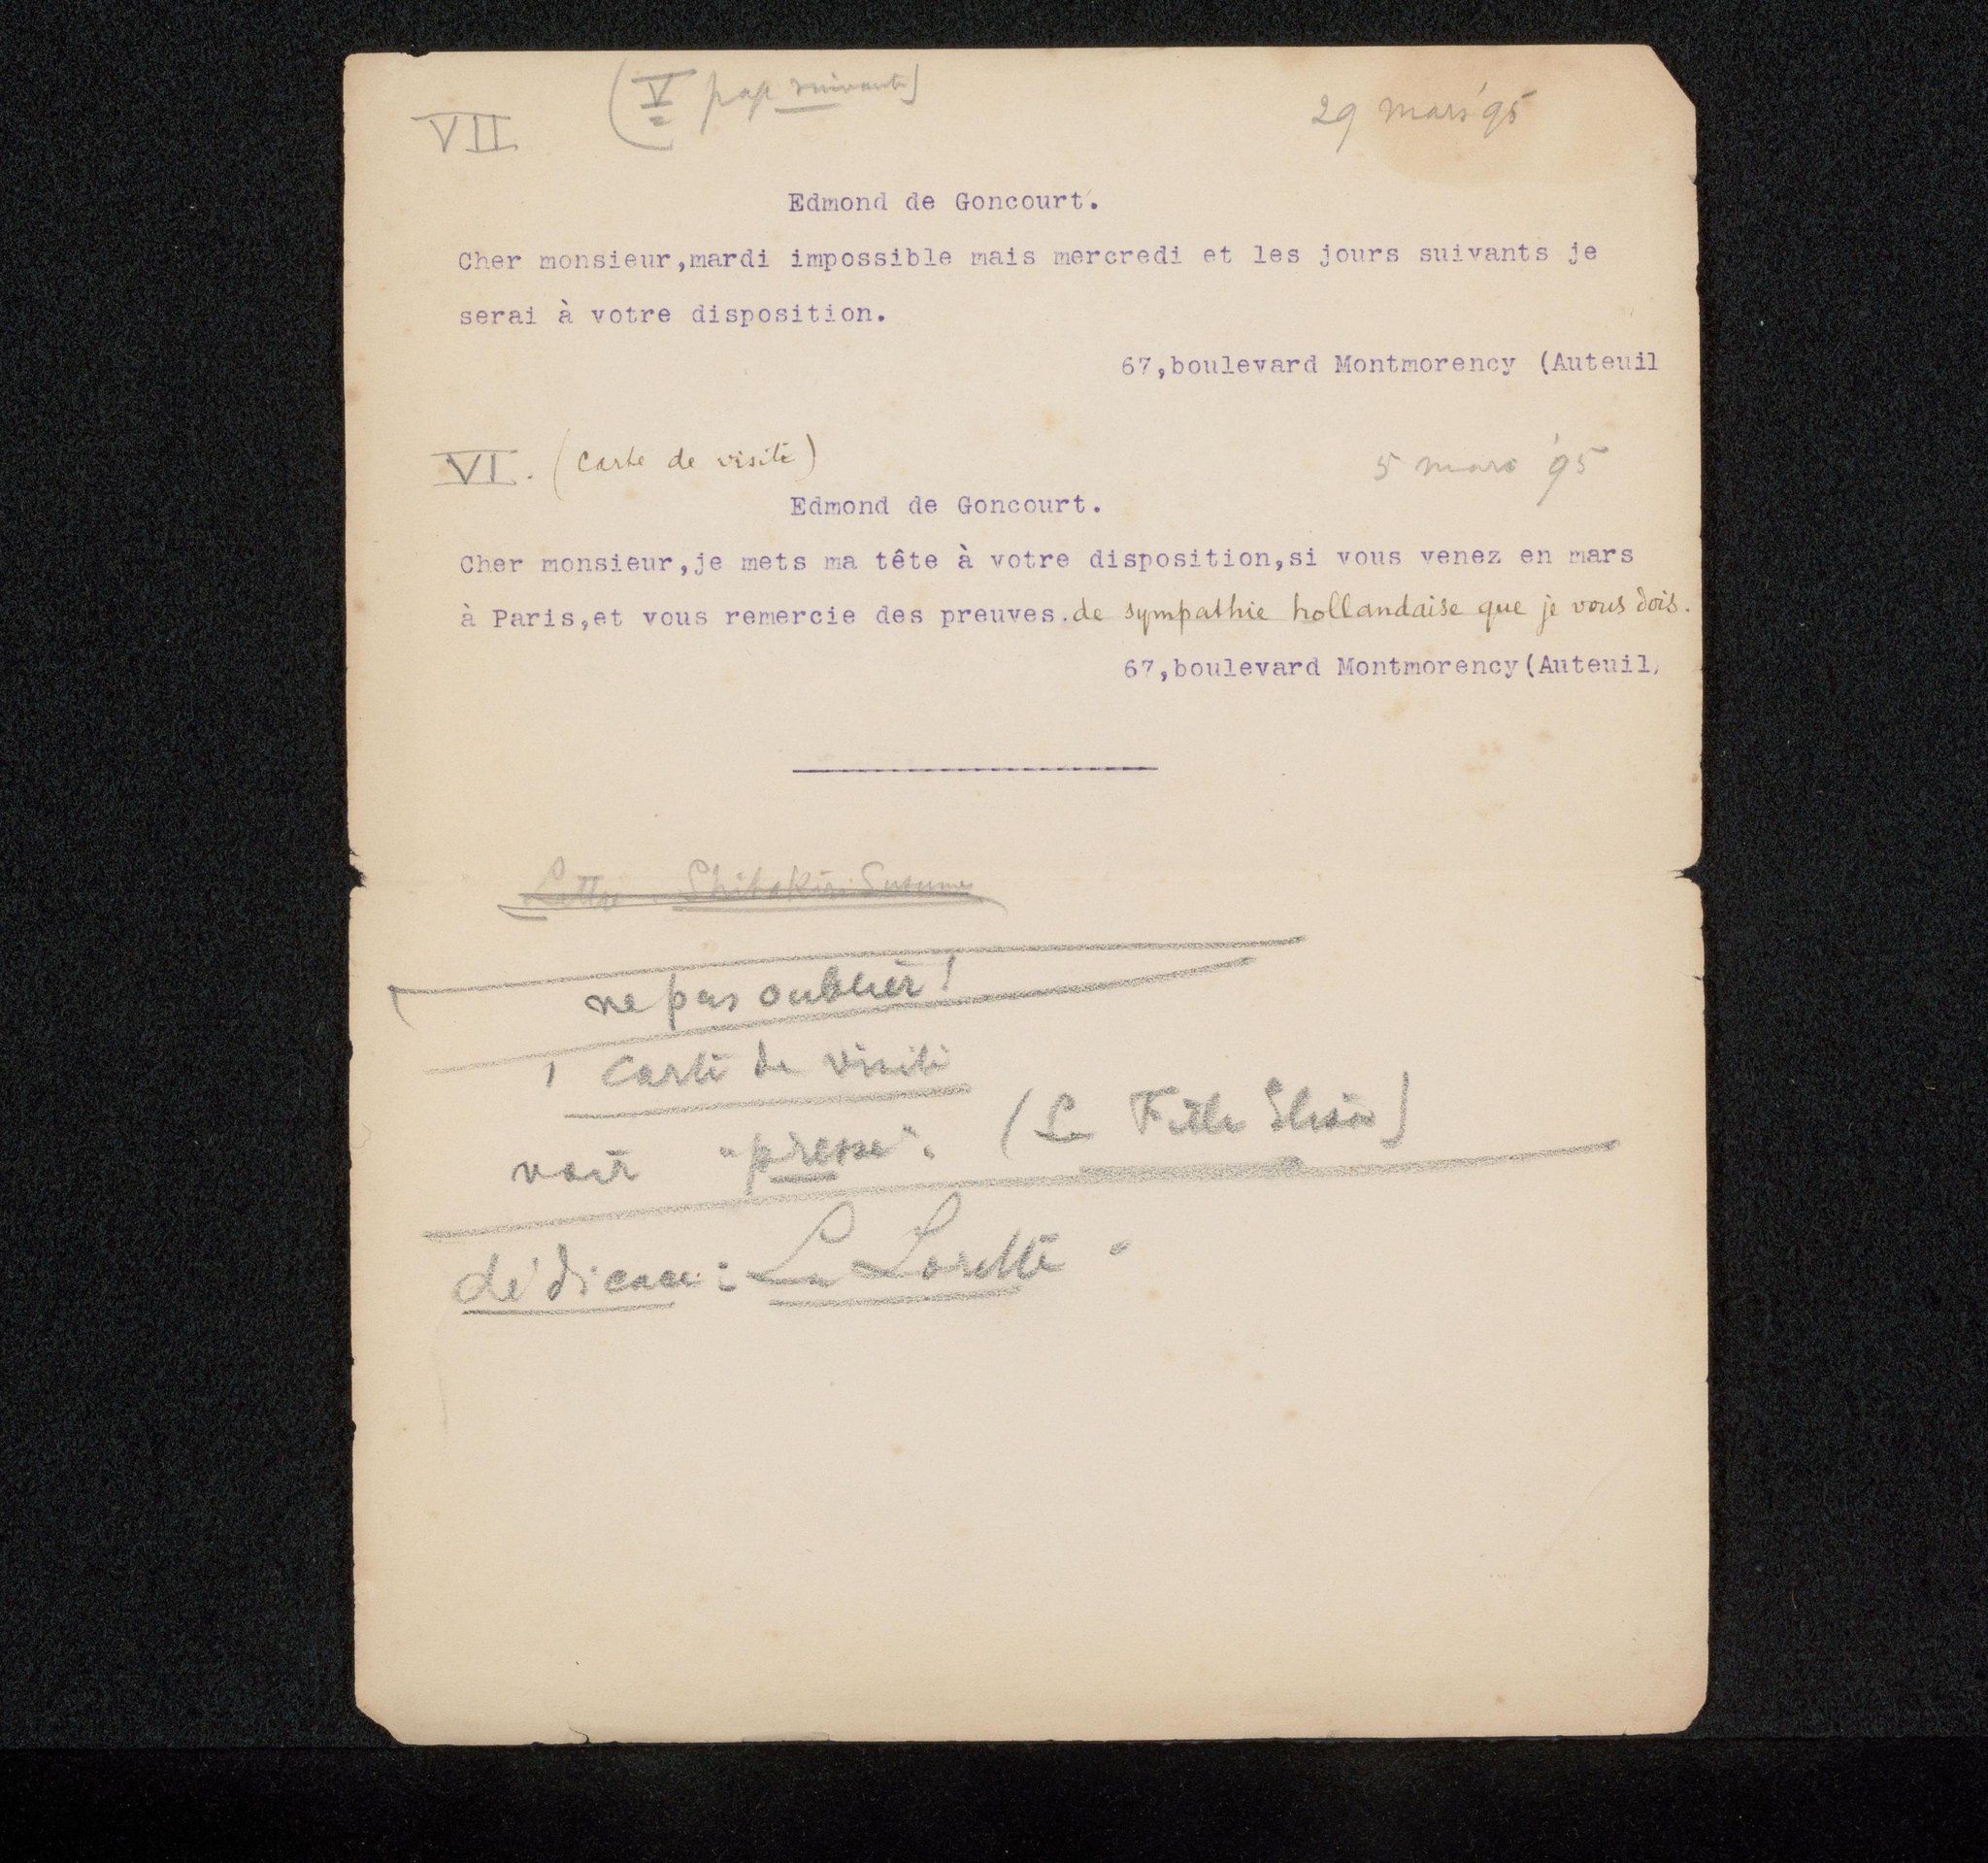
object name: visiting card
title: Visitekaartje aan Philip Zilcken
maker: edmond de goncourt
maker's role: draughtsman, painter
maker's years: 1822-1896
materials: cardboard, ink, pencil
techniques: pen, printing, writing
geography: auteuil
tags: the hague, painter, philip zilcken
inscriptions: collector's mark: ‘RPK’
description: Bevat een transcriptie samen met de transcriptie van RP-D-1982-43-GONCOURT(EDMONDDE)-9A.